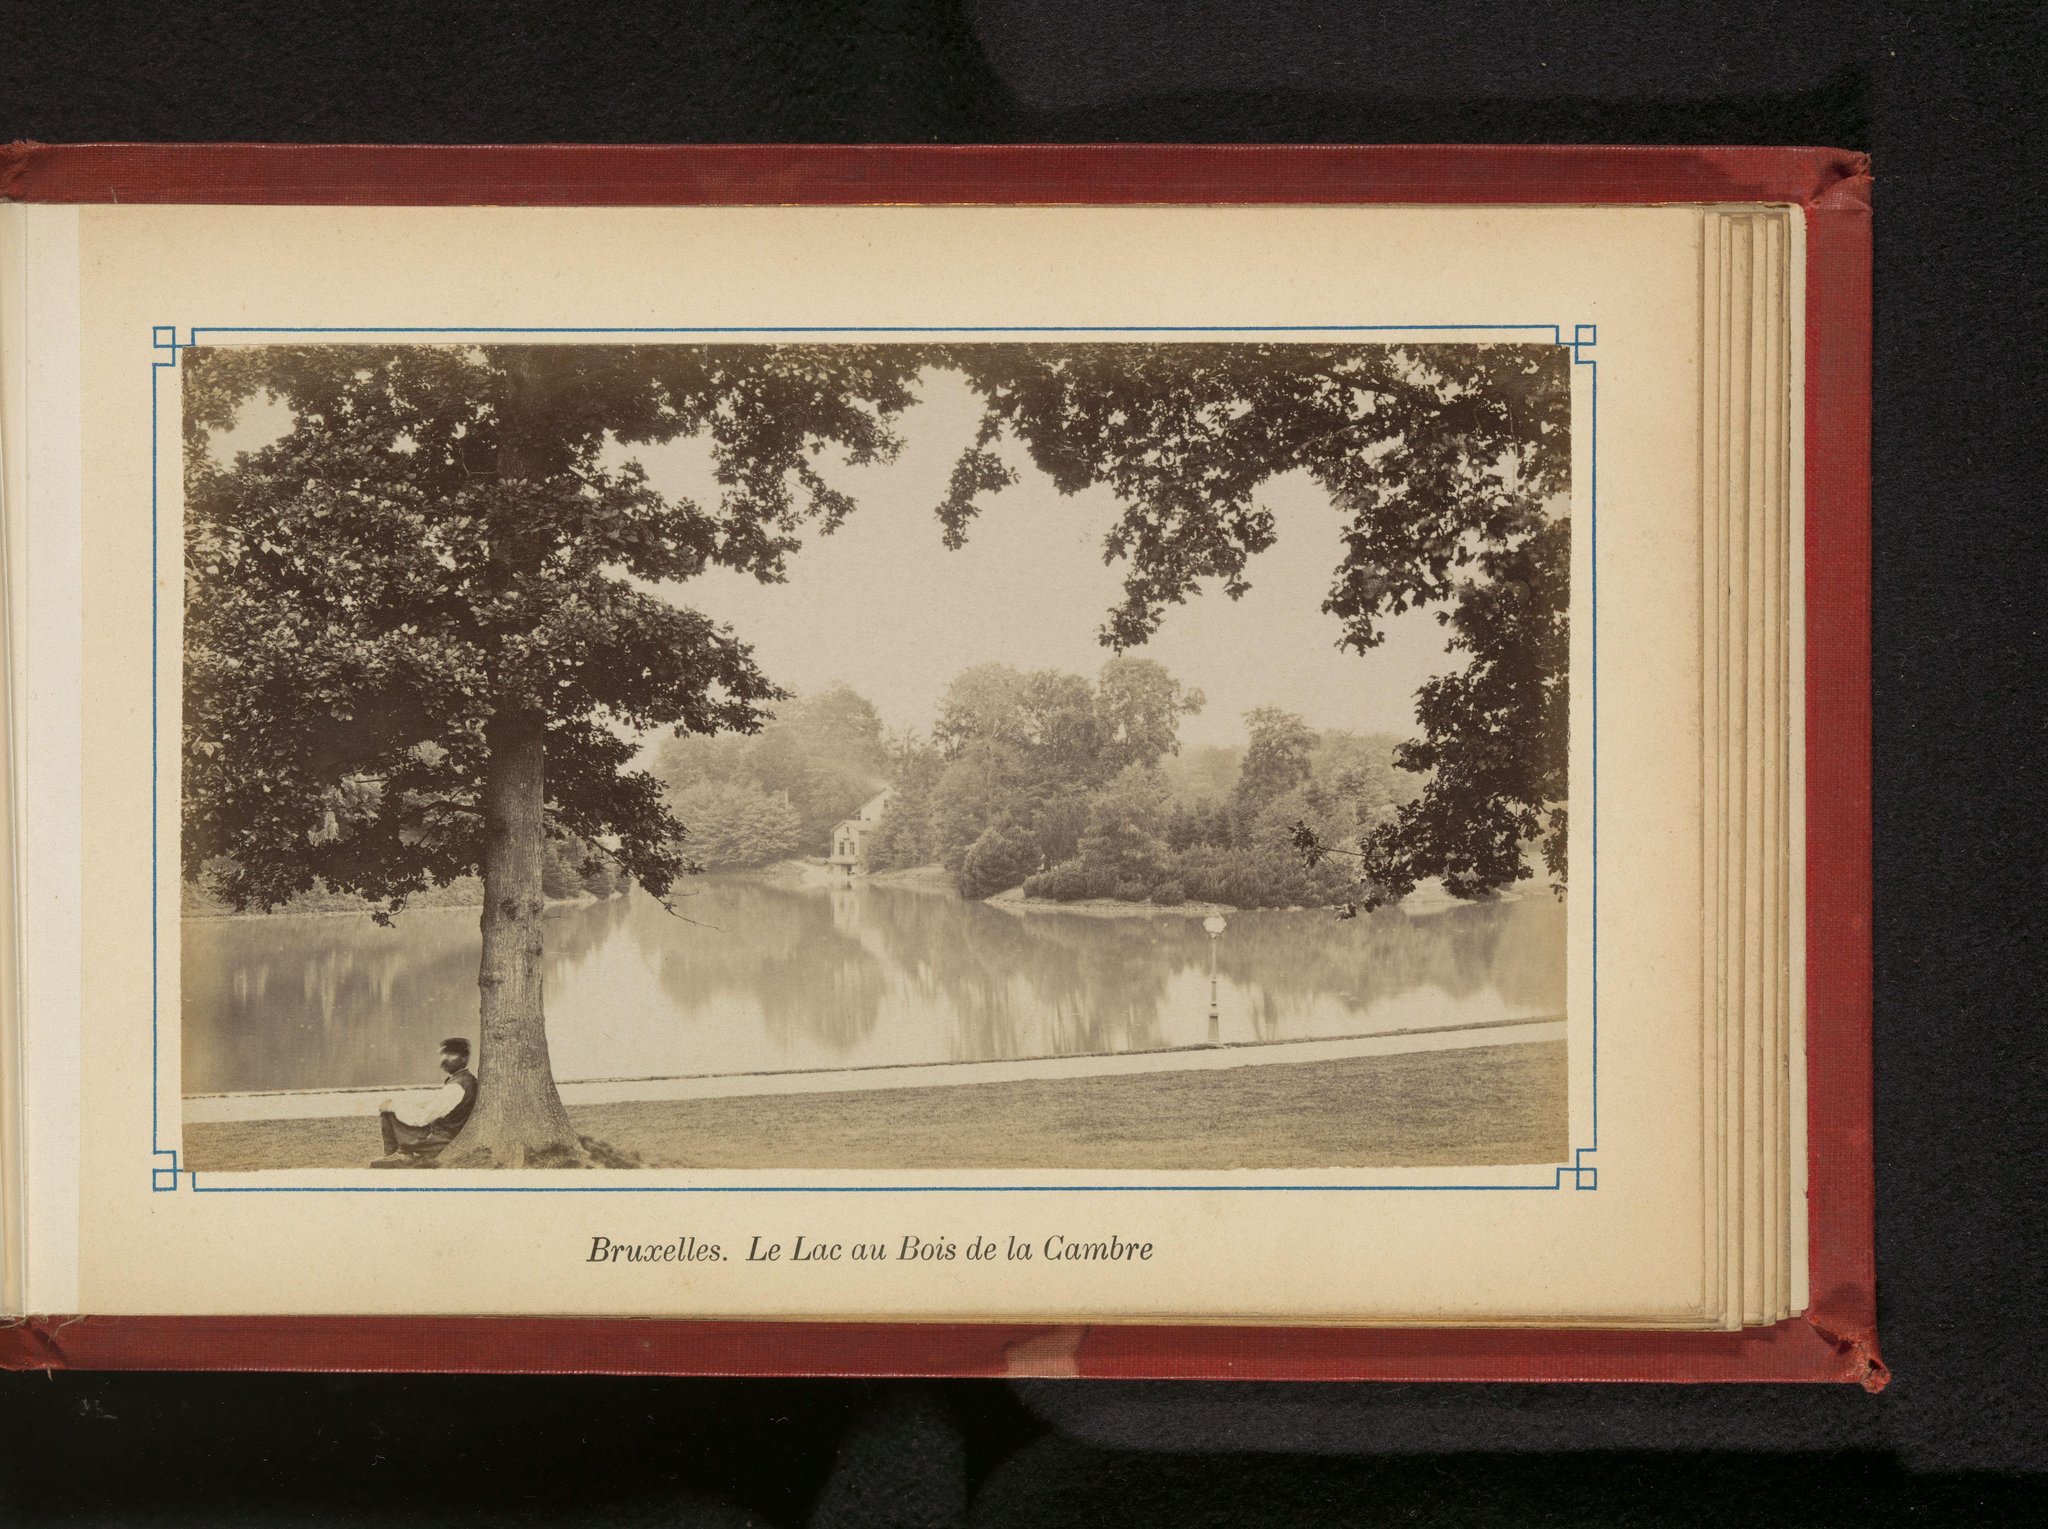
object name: page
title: Gezicht op het Ter Kamerenbos te Brussel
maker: Anonymous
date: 1875-1880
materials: photographic support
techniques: albumen print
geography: ter kamerenbos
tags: river mouth, estuary, forest, wood (+ landscape with figures, staffage)